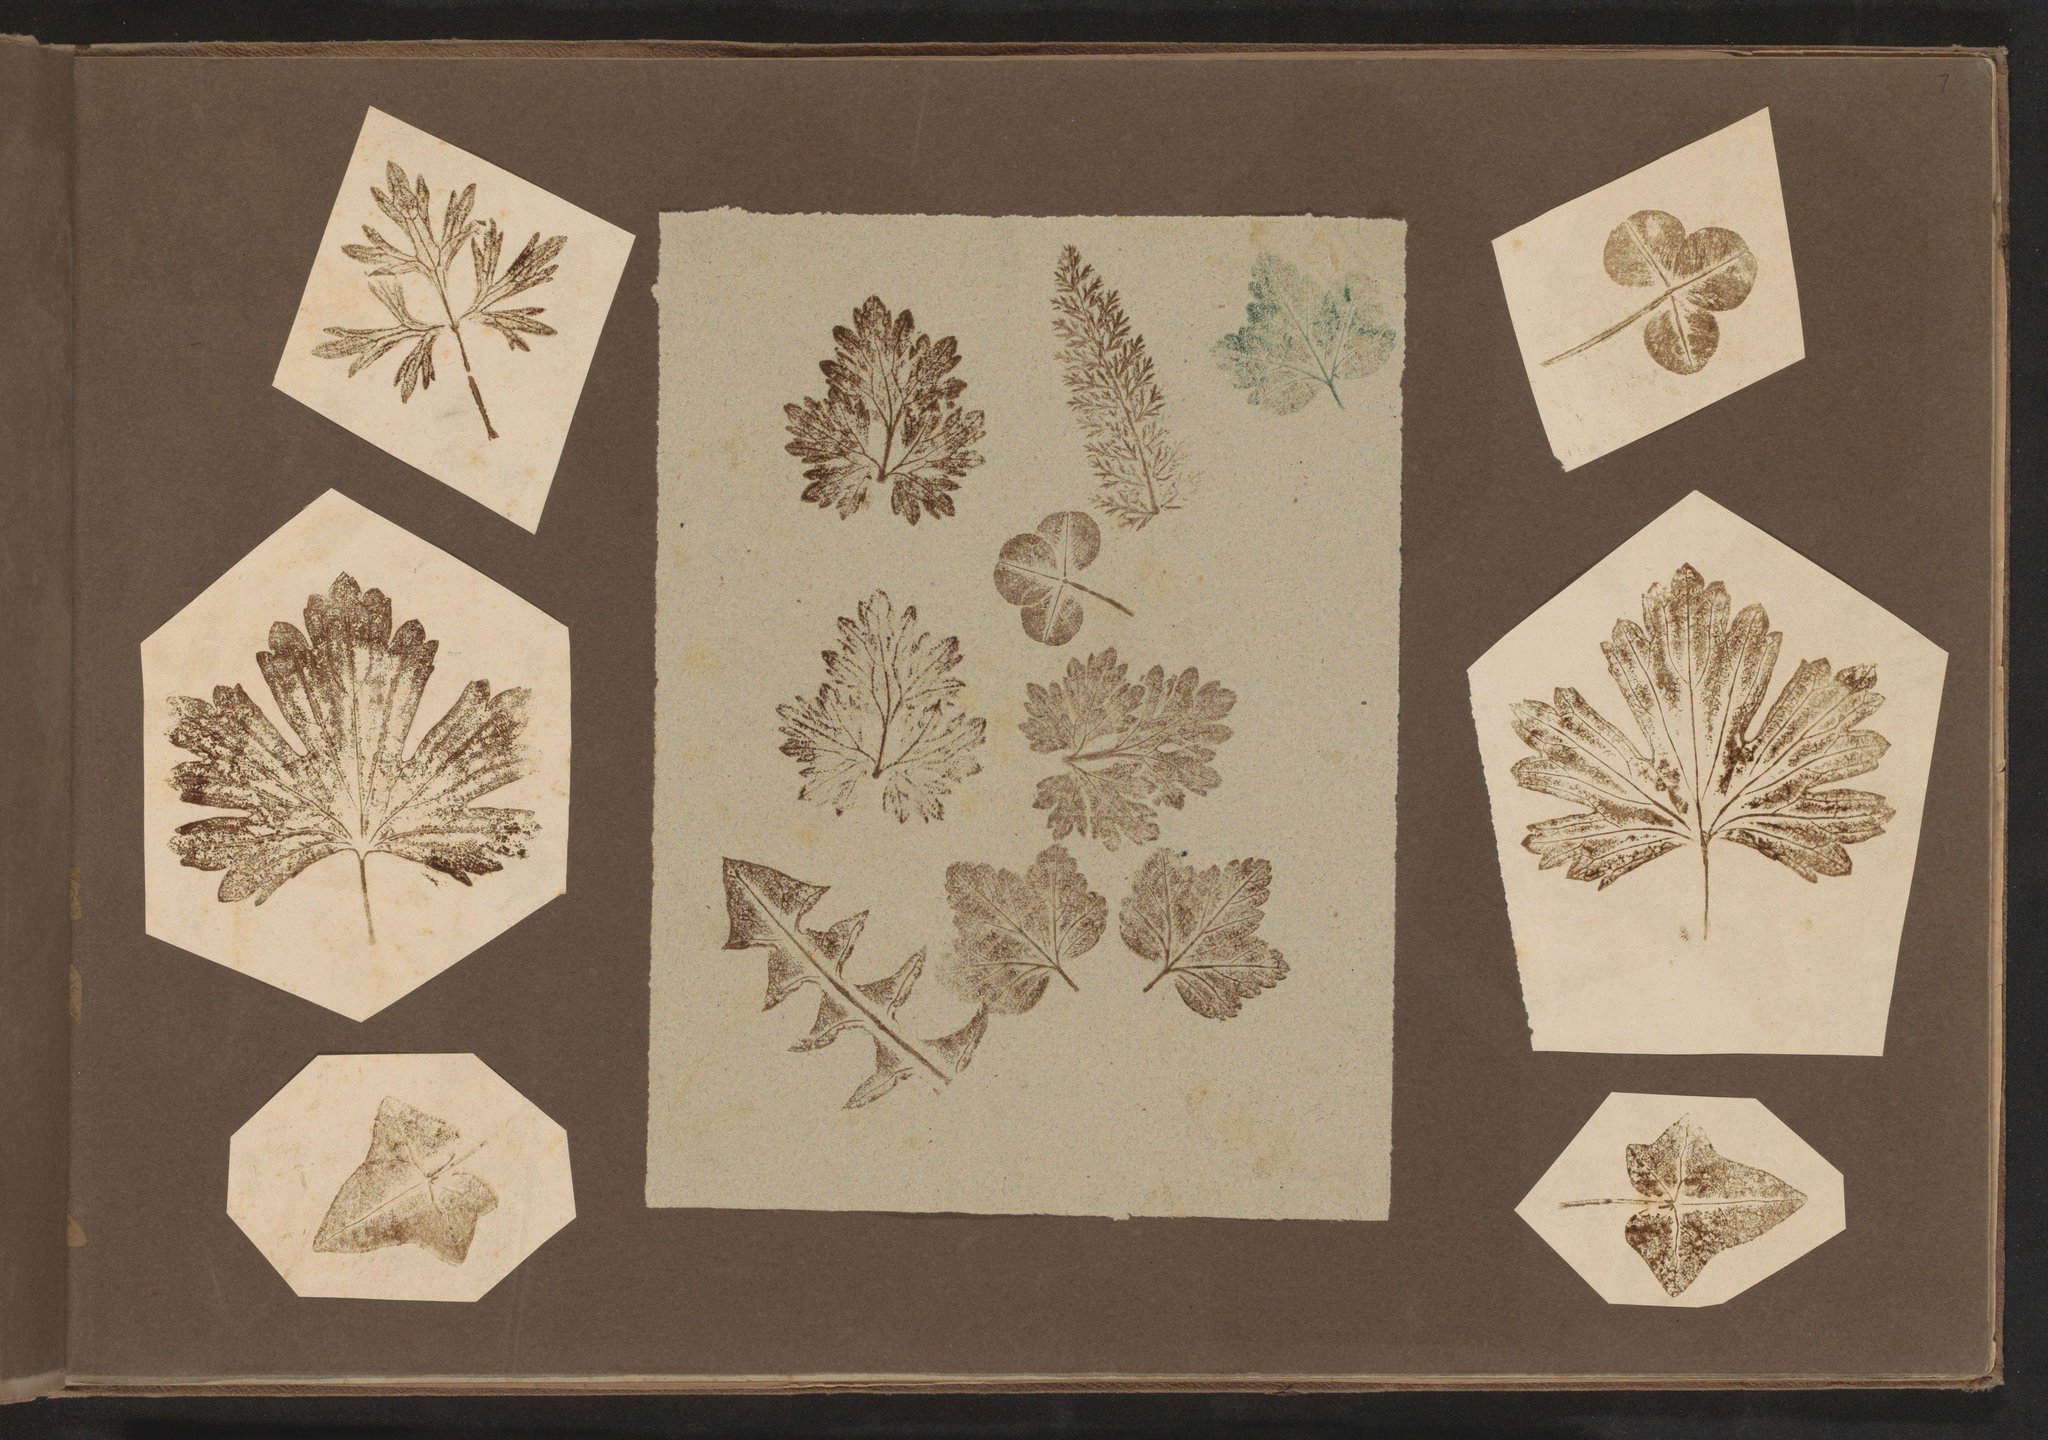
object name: sketchbook leaf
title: Afdrukken van bladeren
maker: pierre joseph hubert cuypers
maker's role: draughtsman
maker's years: 1827-1921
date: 1837-1921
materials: ink, paper, pencil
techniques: printing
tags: trees (+ leaf)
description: Blad 7 recto uit een schetsboek met 23 bladen.